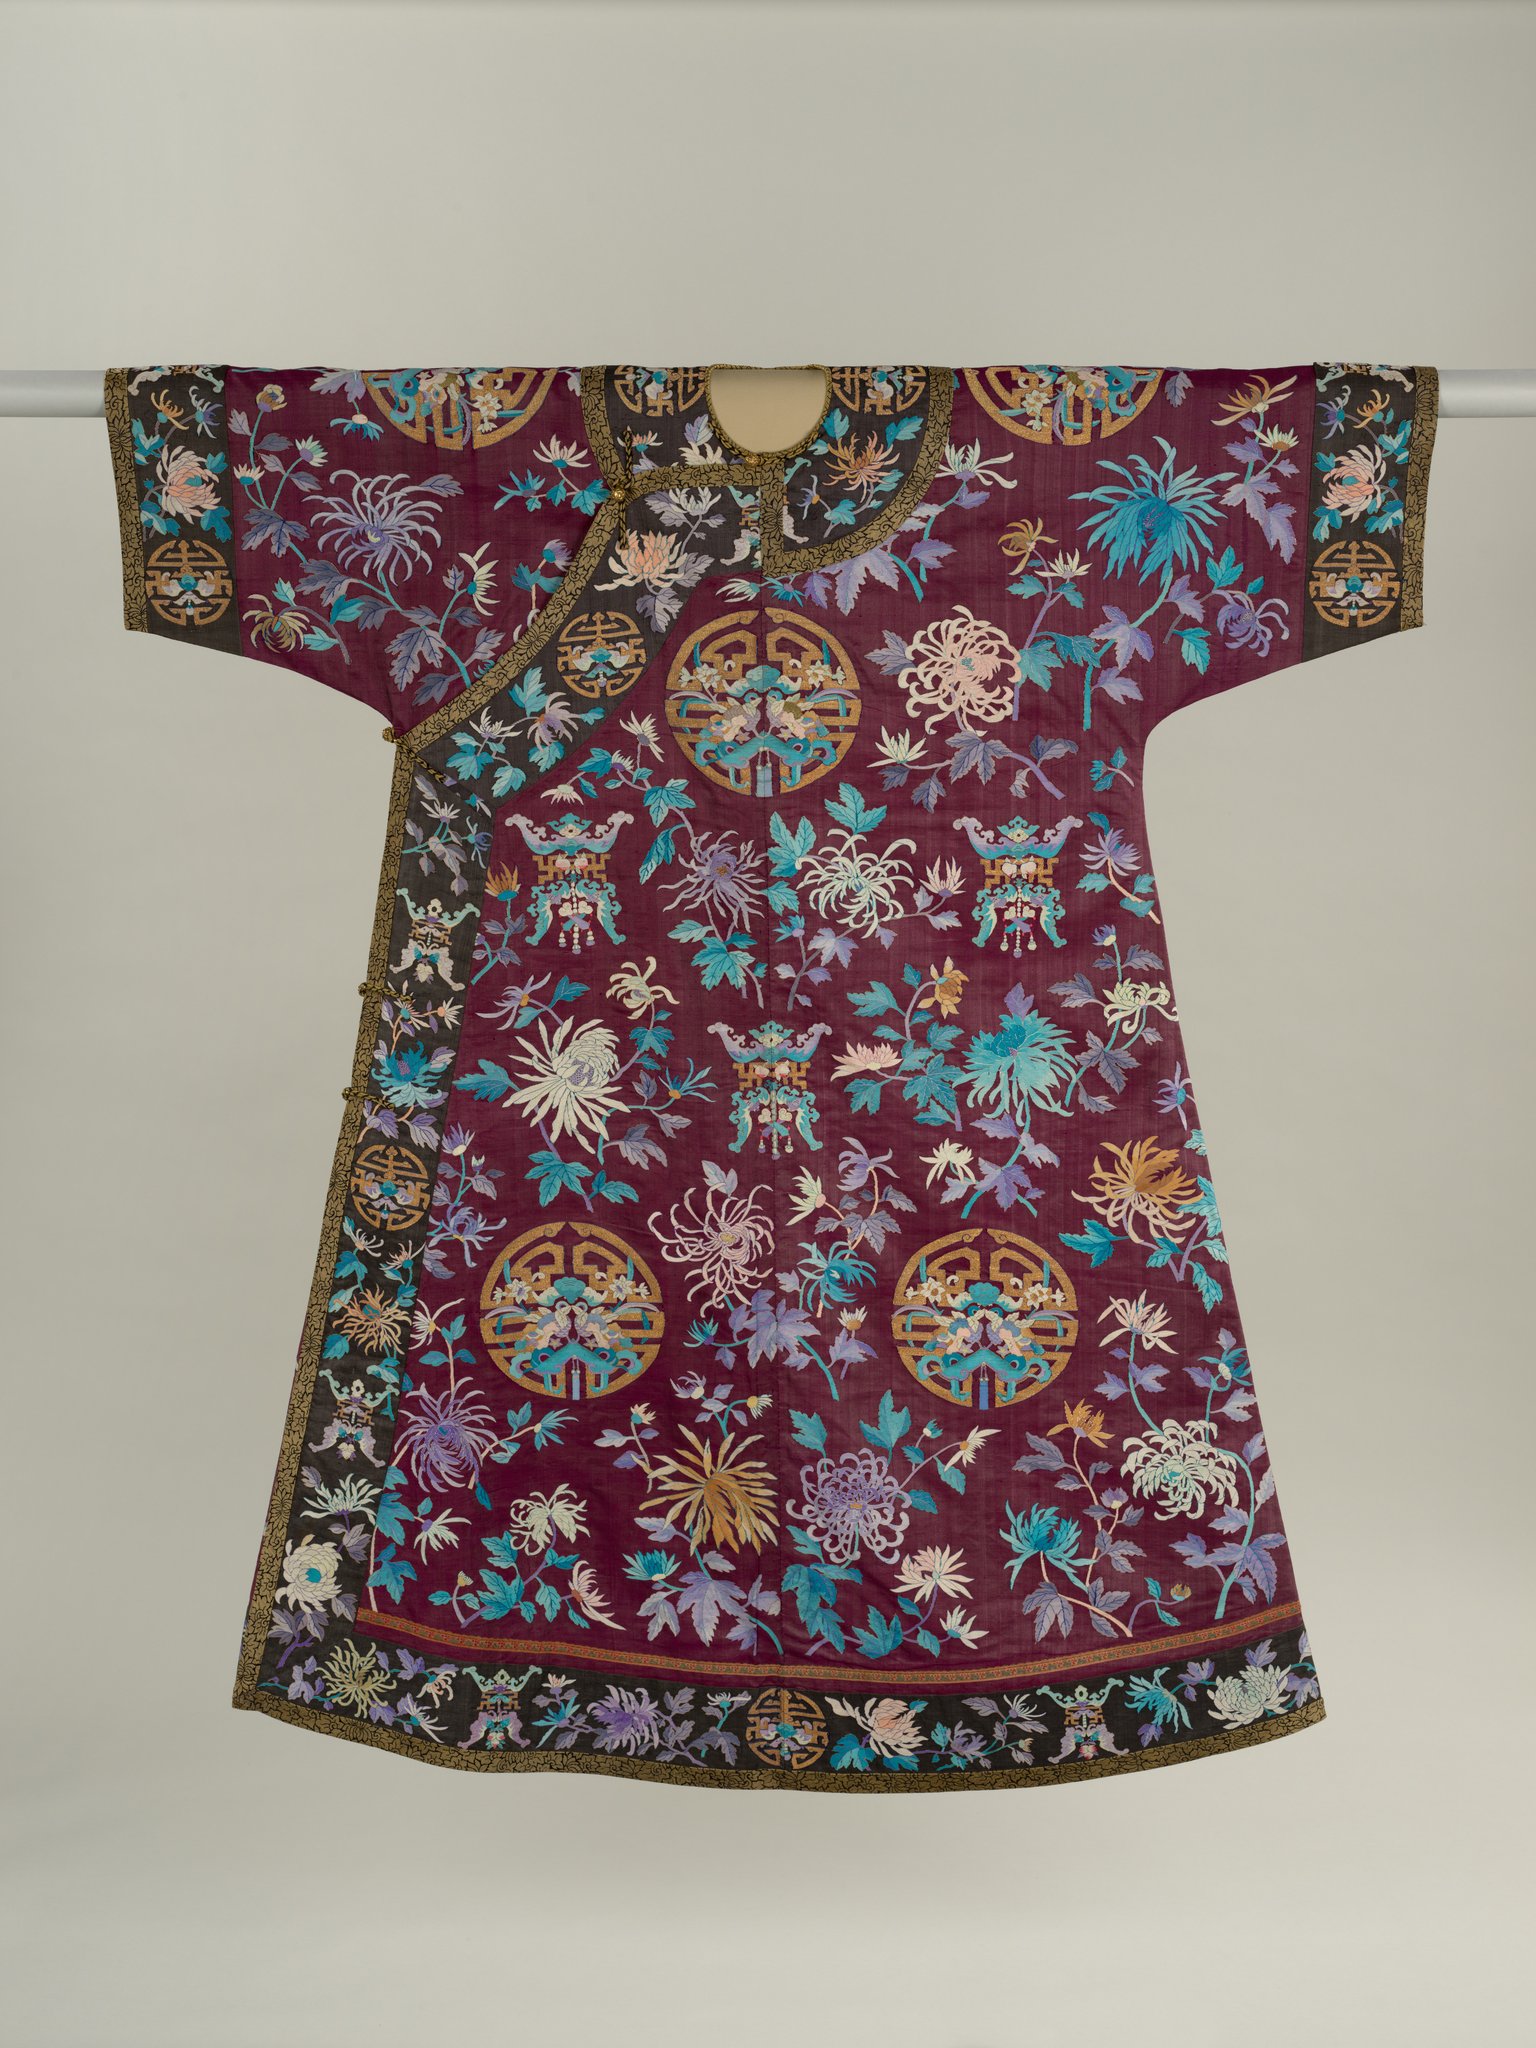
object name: robe, birthday or ceremonial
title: Ceremonial Birthday Robe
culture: chinese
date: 1867-1900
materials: silk